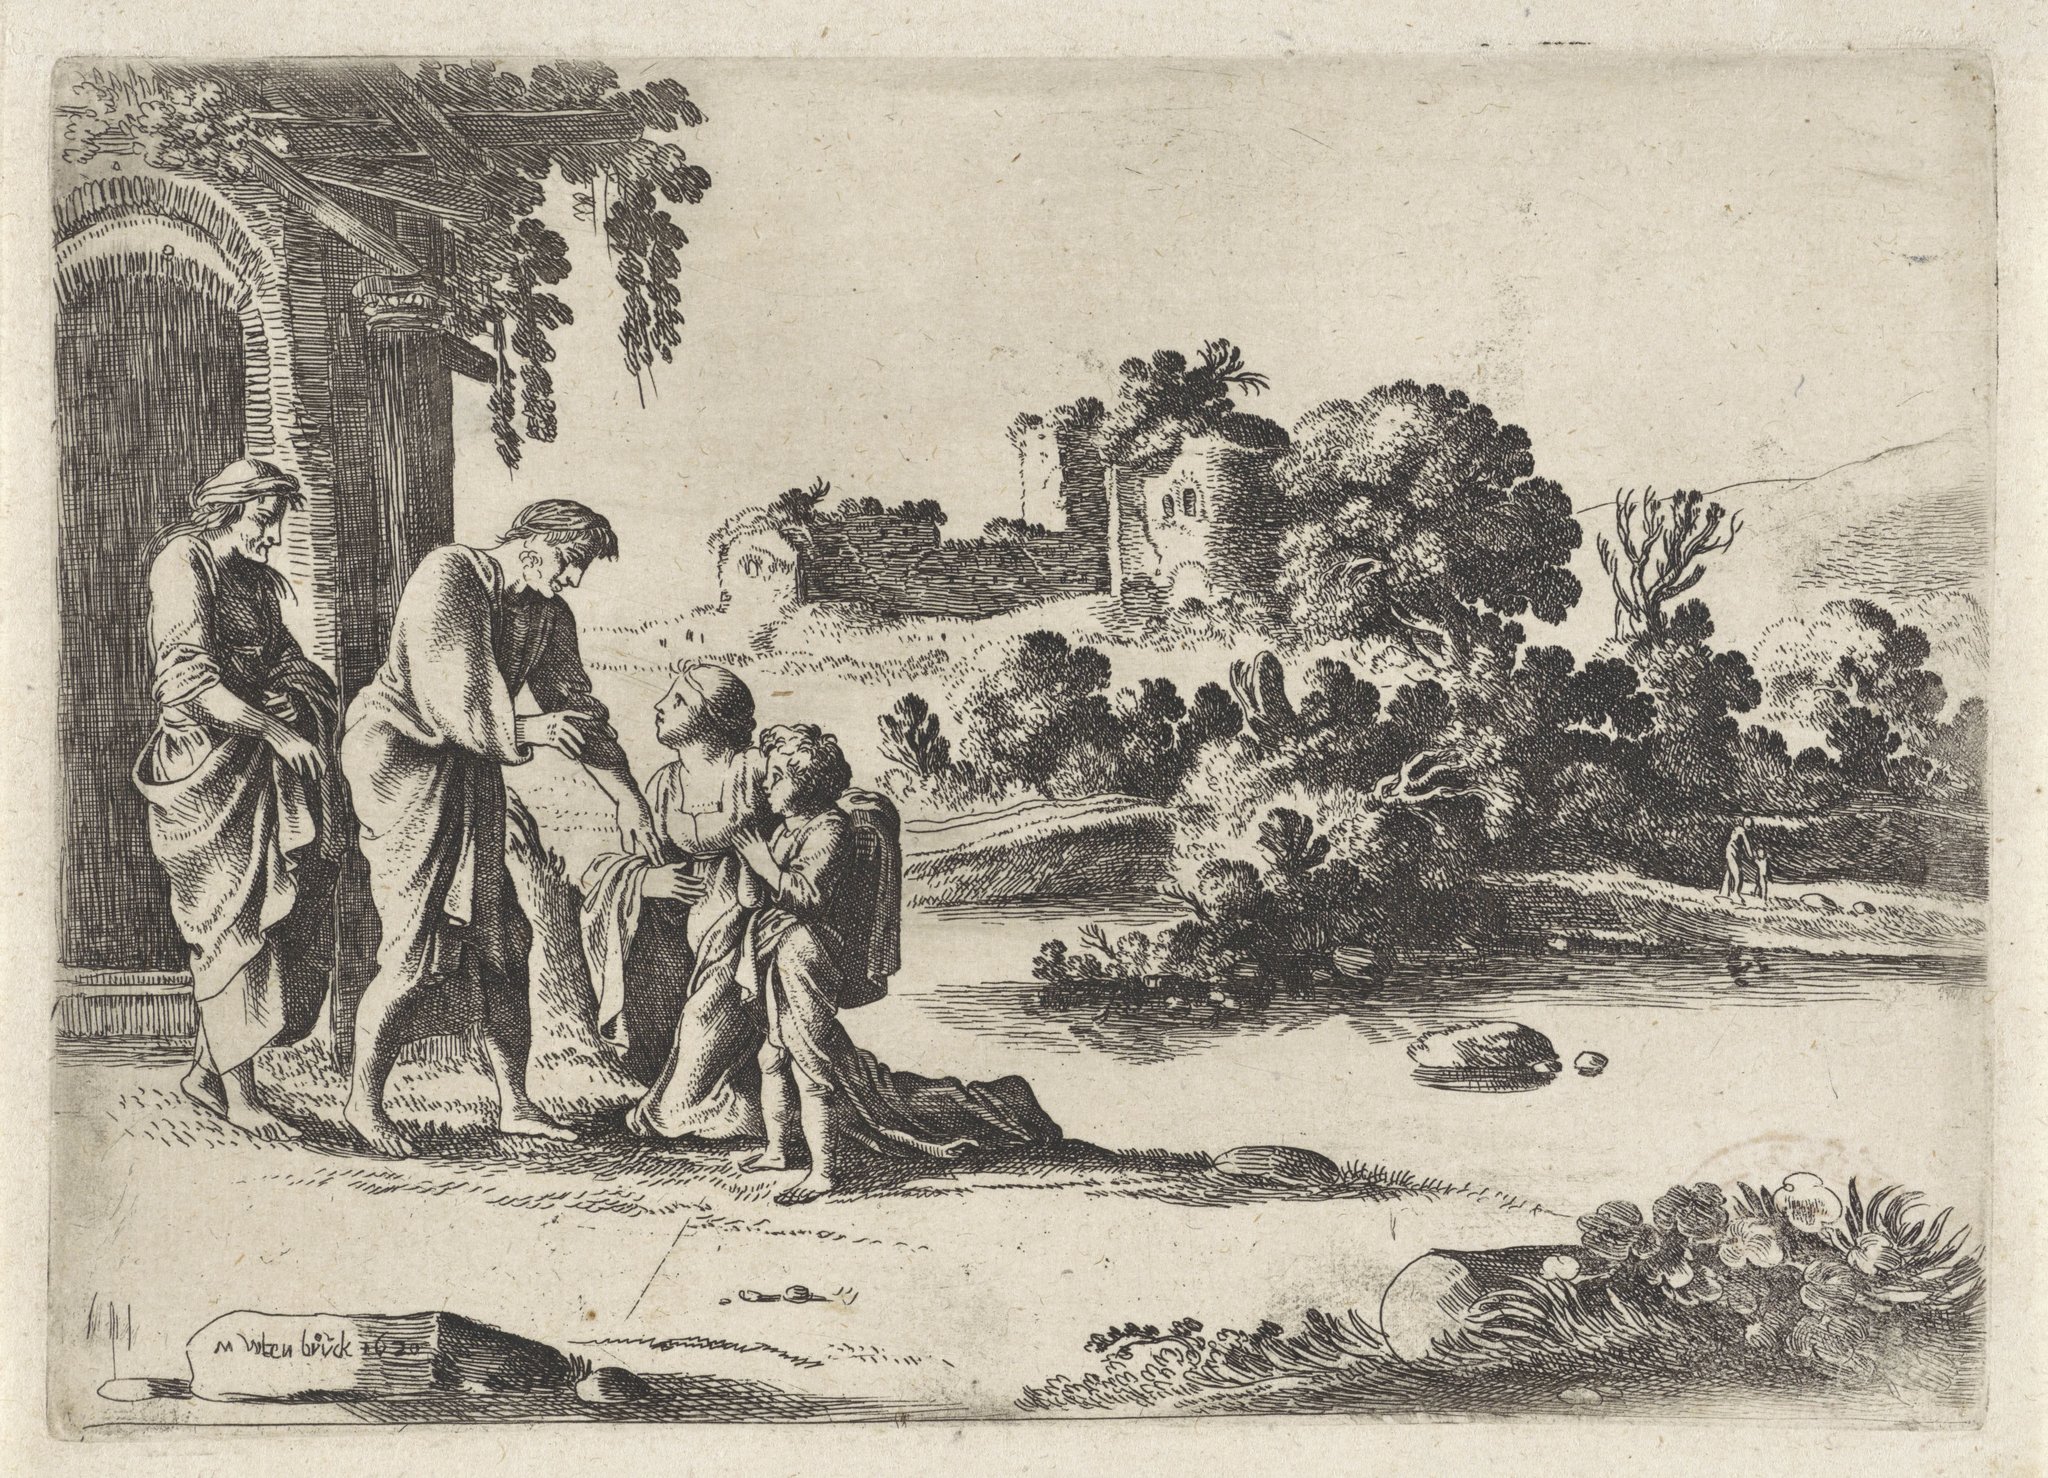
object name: print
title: Het verhaal van Hagar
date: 1620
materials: paper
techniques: etching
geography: the hague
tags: the banishment of hagar and ishmael (genesis 21:9-21)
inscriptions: collector's mark: Lugt 240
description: Sara en Abraham kijken neer op de knielende Hagar. Naast haar staat Ismael. Op de achtergrond een vijver en enkele ruïnes. In de linkerbenedenhoek is de prent genummerd als III.